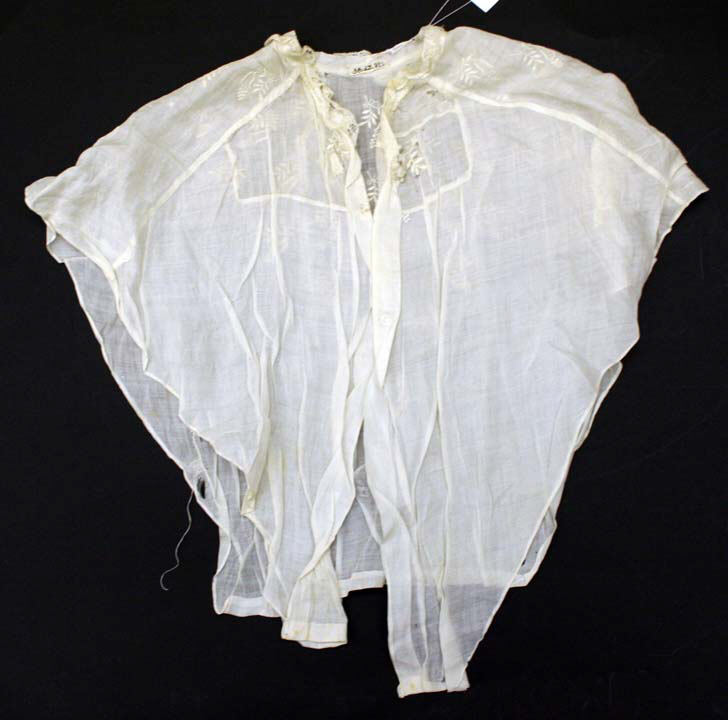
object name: fichu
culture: european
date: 1840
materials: cotton